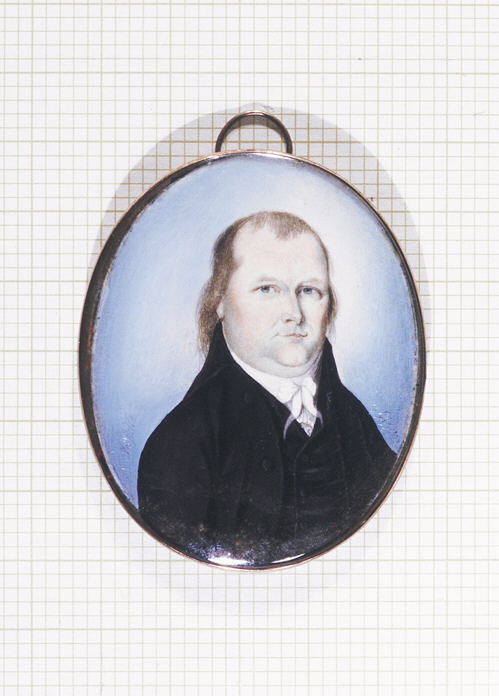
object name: painting, miniature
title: Portrait of a Gentleman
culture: american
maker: william verstille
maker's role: artist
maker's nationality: american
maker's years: 1757-1803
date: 1795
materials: ivory, watercolor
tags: men,portraits